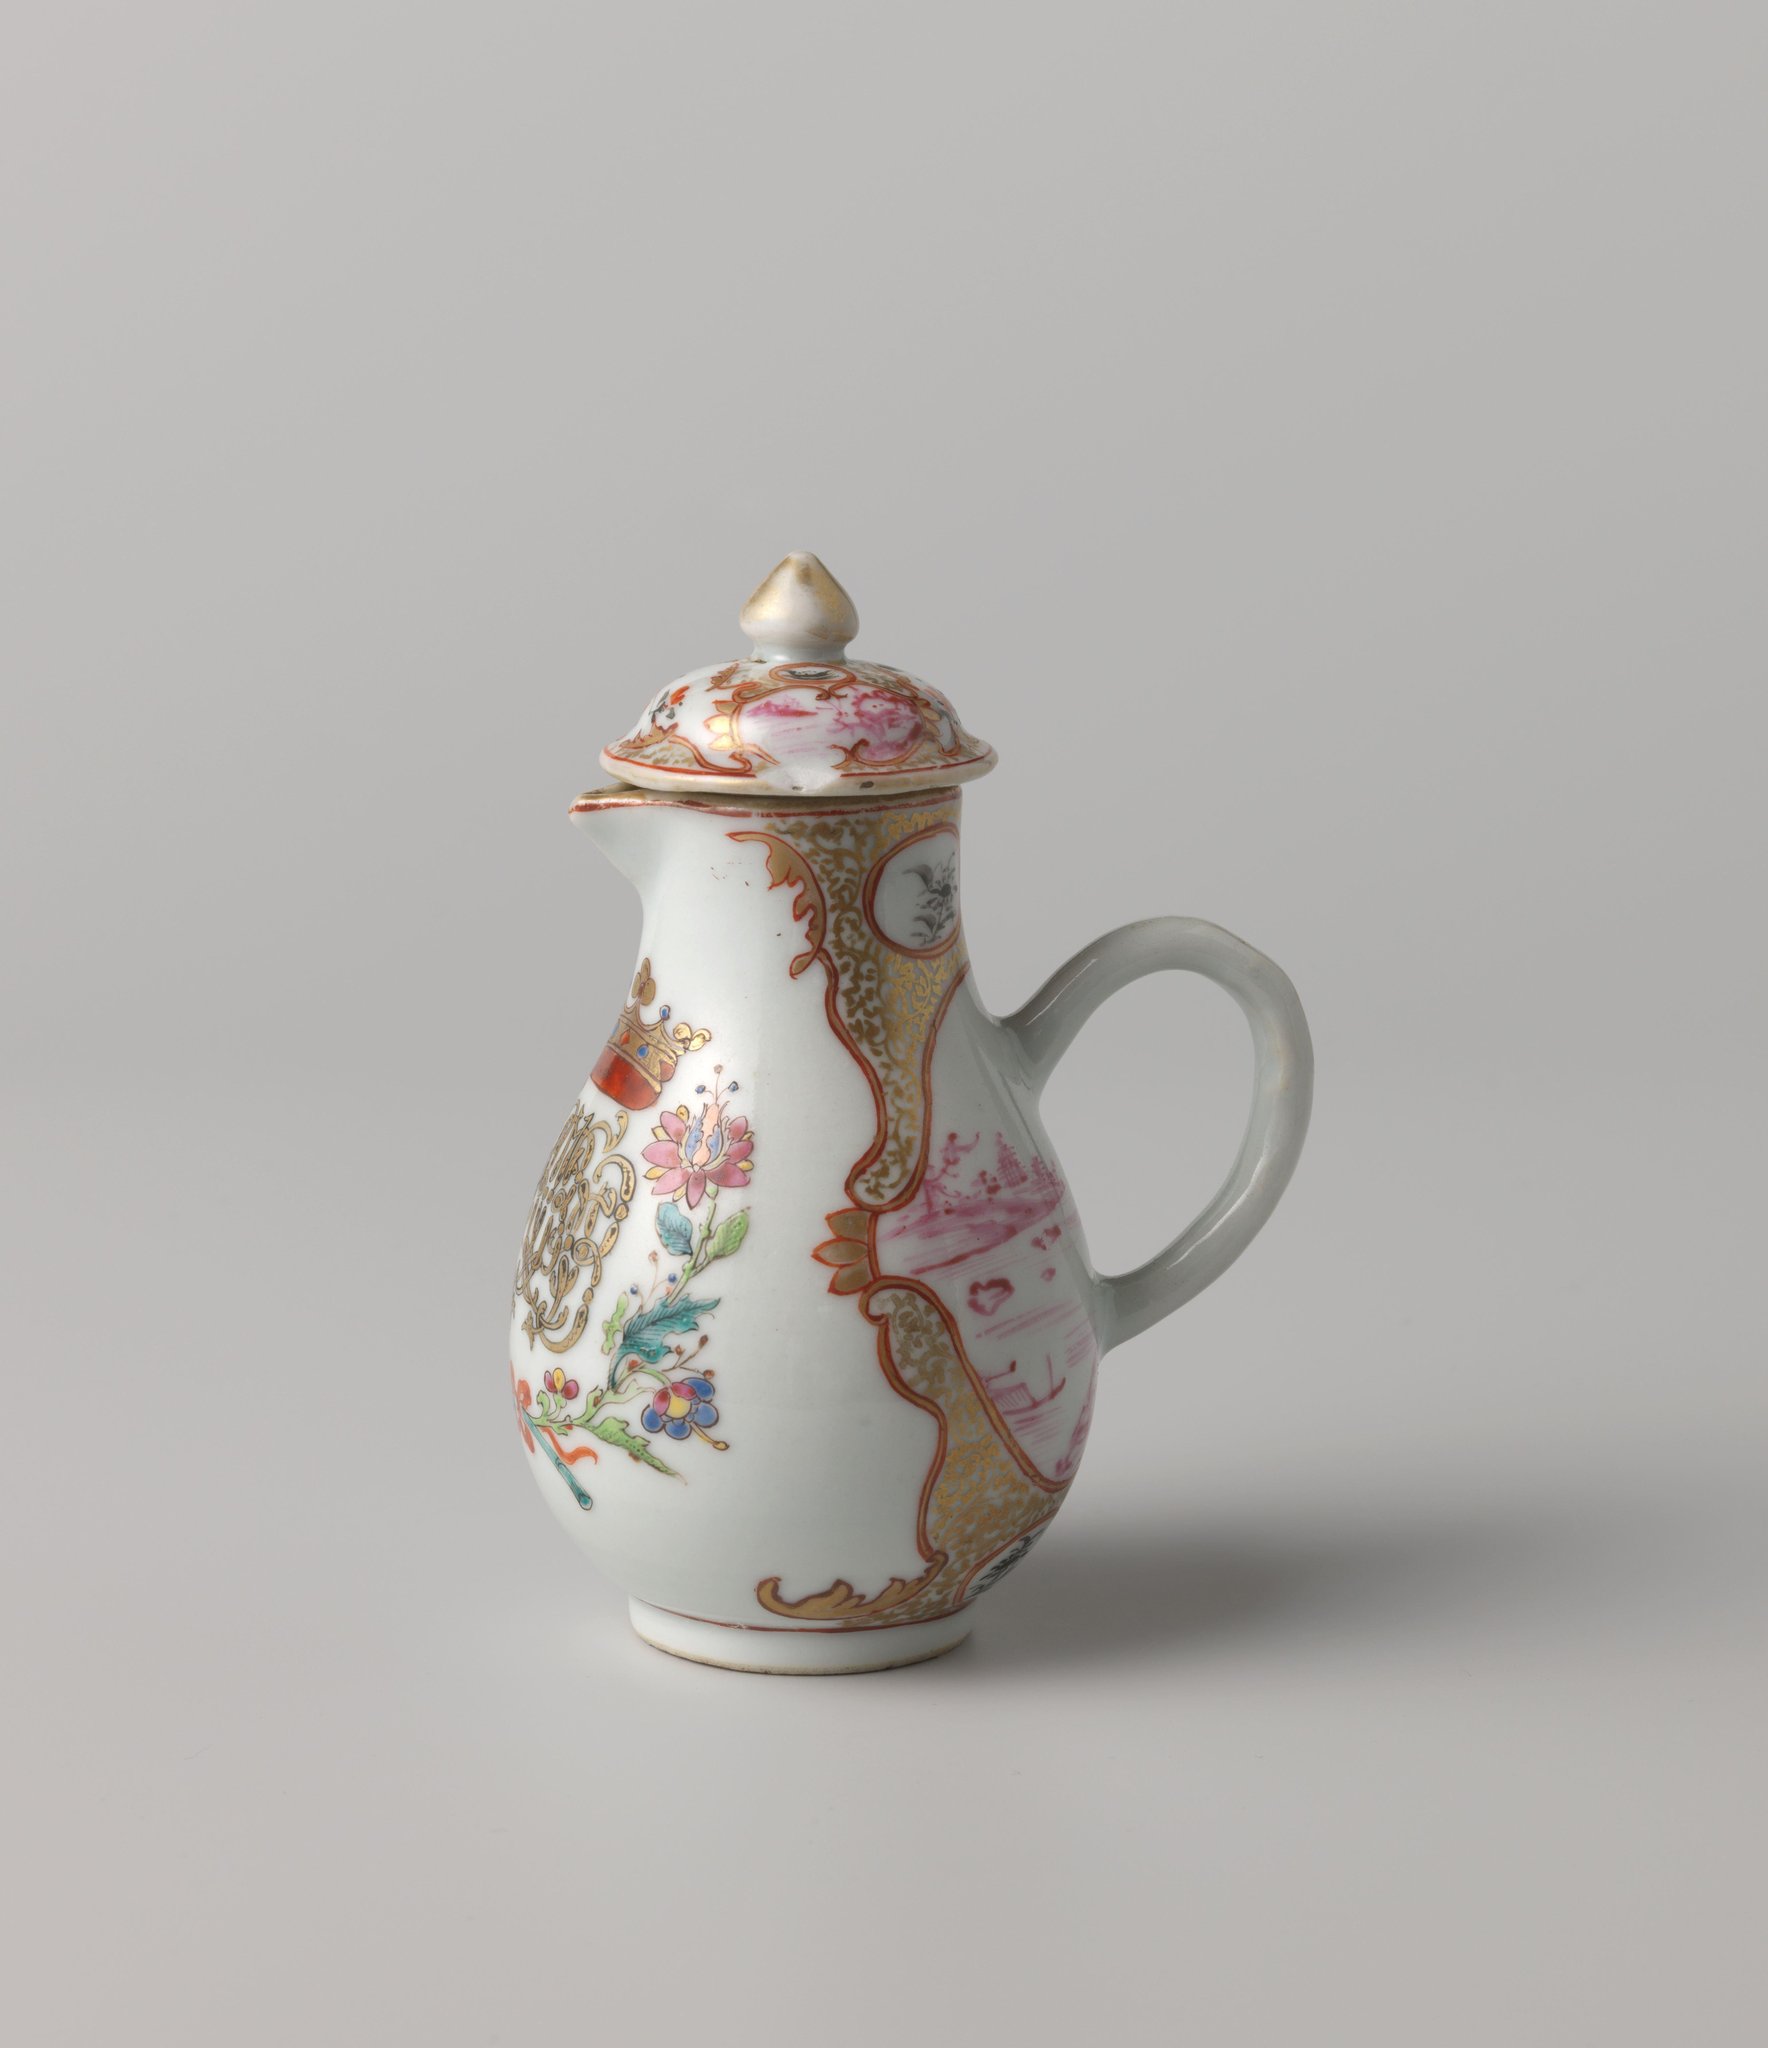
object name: milk jug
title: Pear-shaped milk jug with a crowned, illegible monogram surrounded by two flower sprays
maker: Anonymous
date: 1750-1774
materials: glaze, gold, paint, porcelain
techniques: firing, gilding, turning, vitrification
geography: china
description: Theebus van porselein, 'Chine de Commande'. Versierd met een gekroond spiegelmonogram.